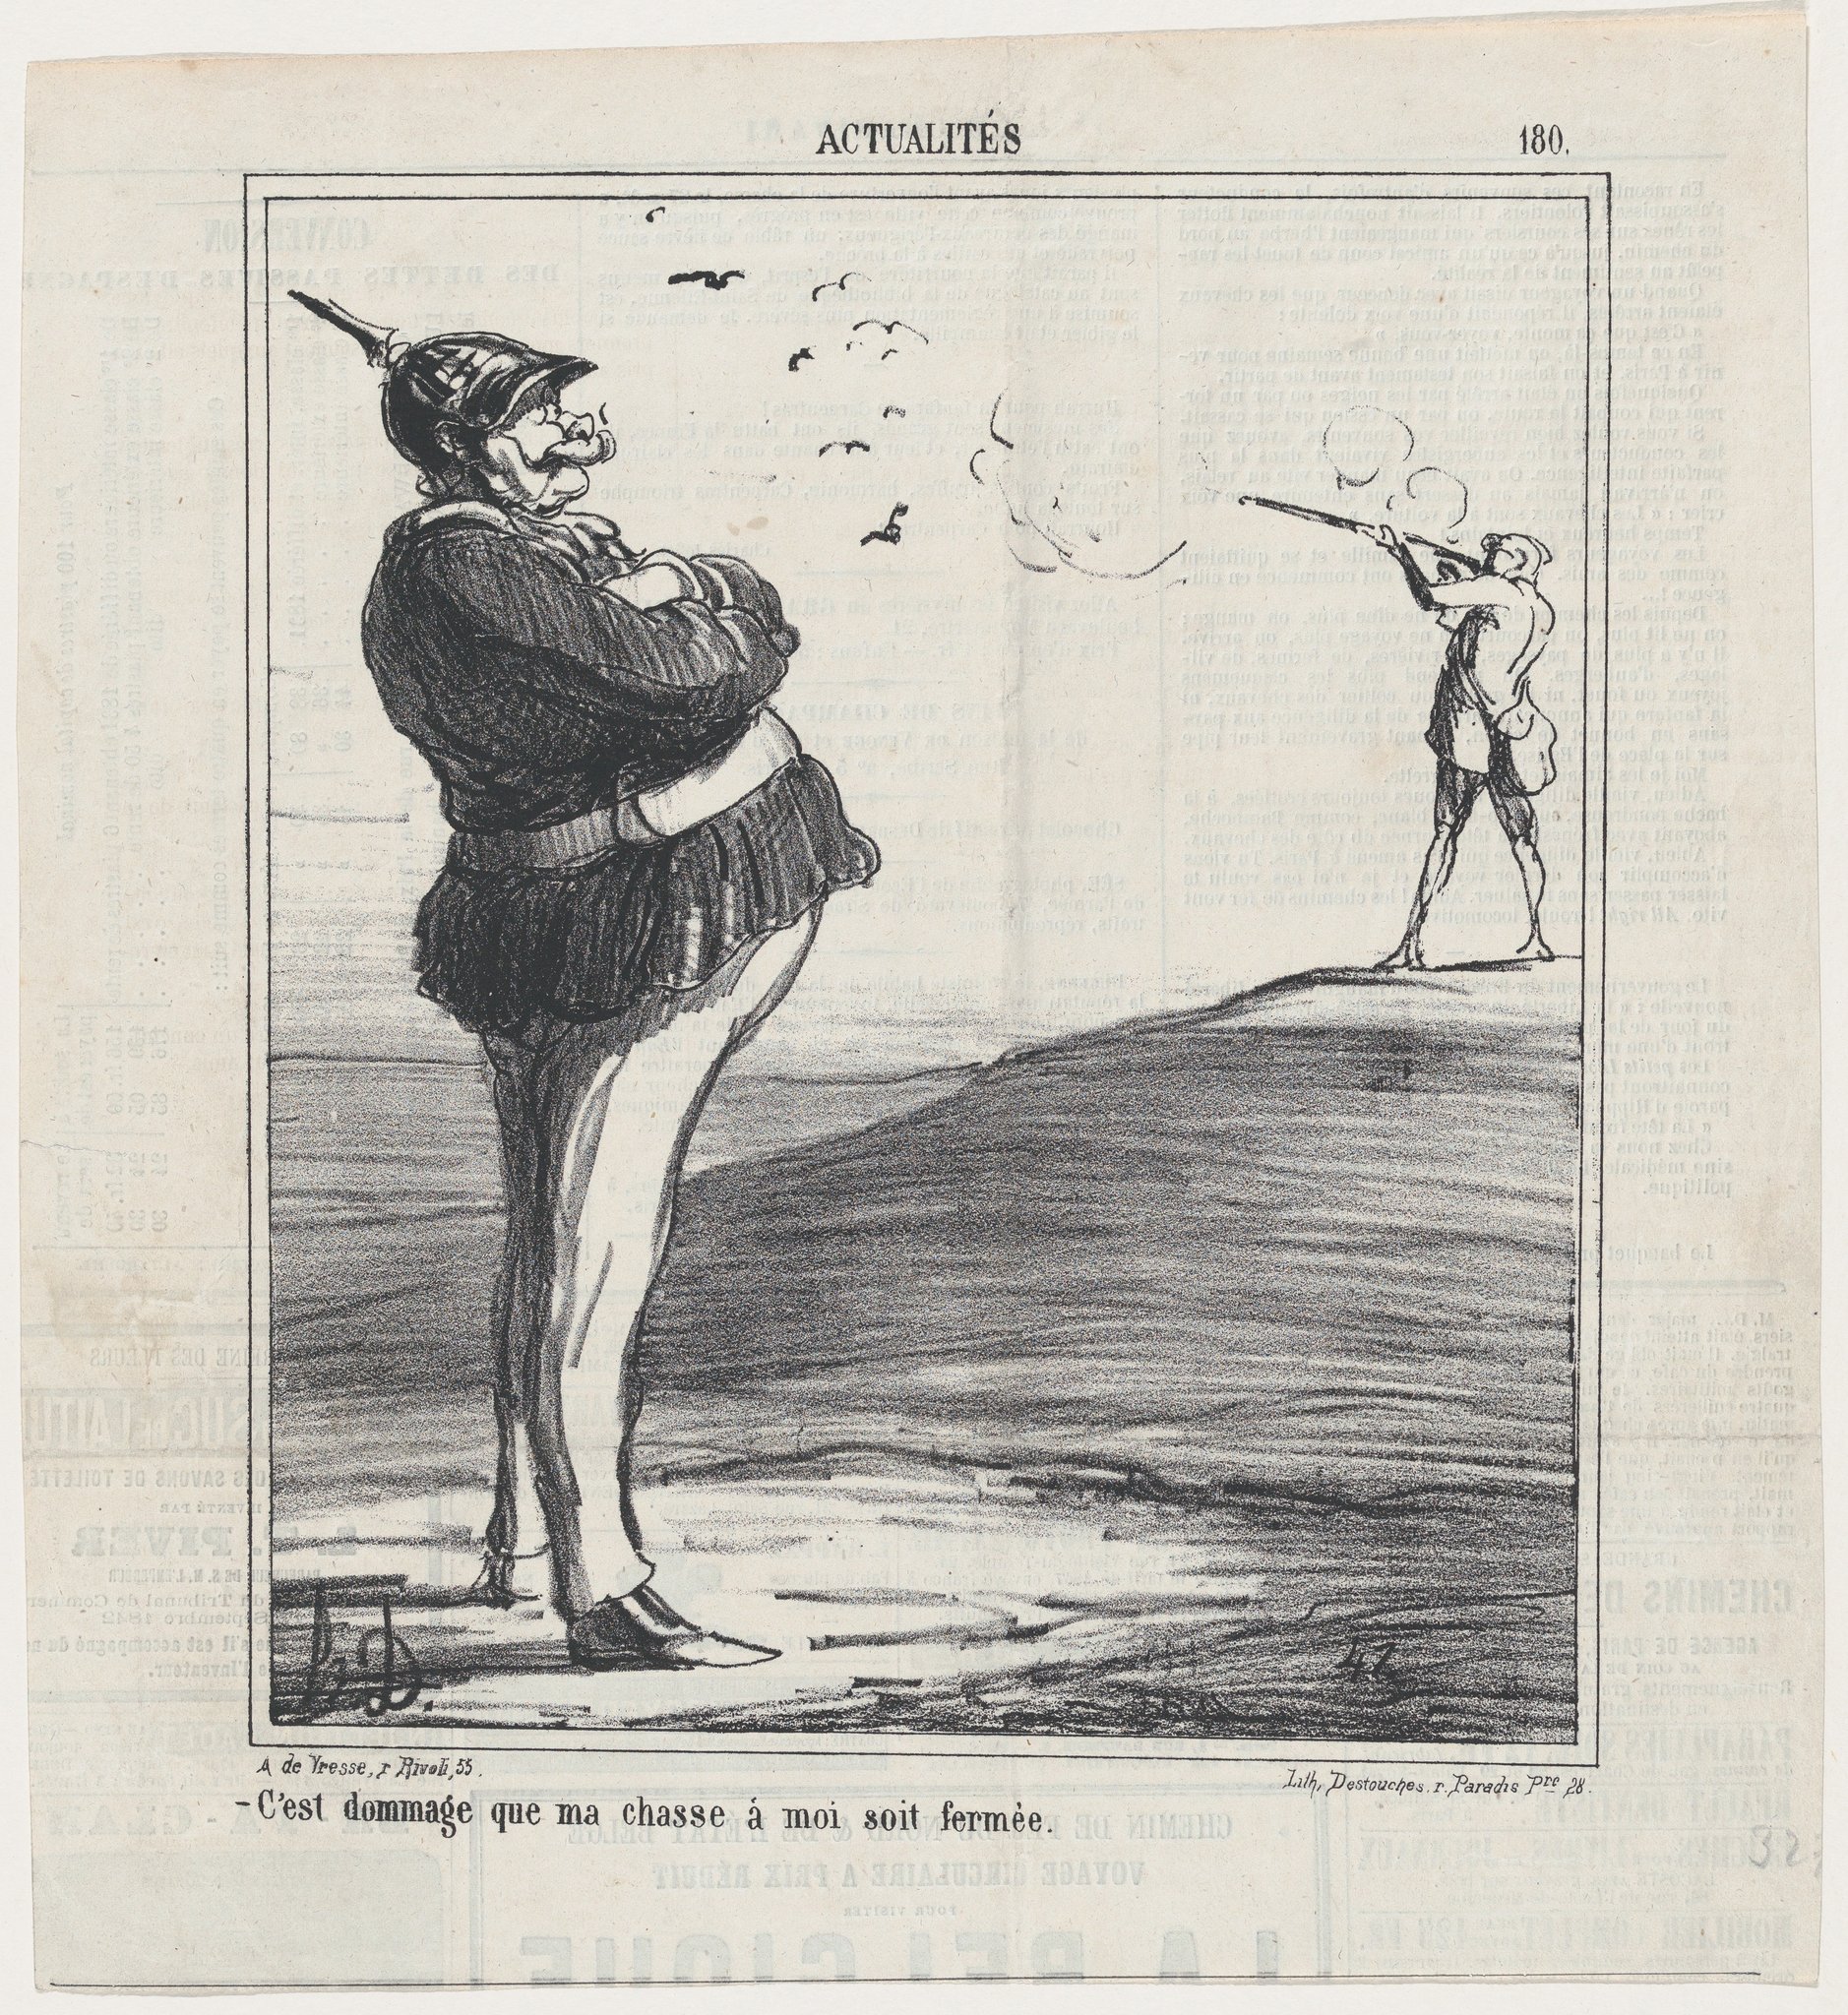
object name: print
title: What a shame that I am not allowed go hunting, from 'News of the day,' published in "Le Charivari"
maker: honoré daumier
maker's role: artist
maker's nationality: french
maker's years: 1808-1879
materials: paper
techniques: lithograph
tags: birds,soldiers,men,hunting